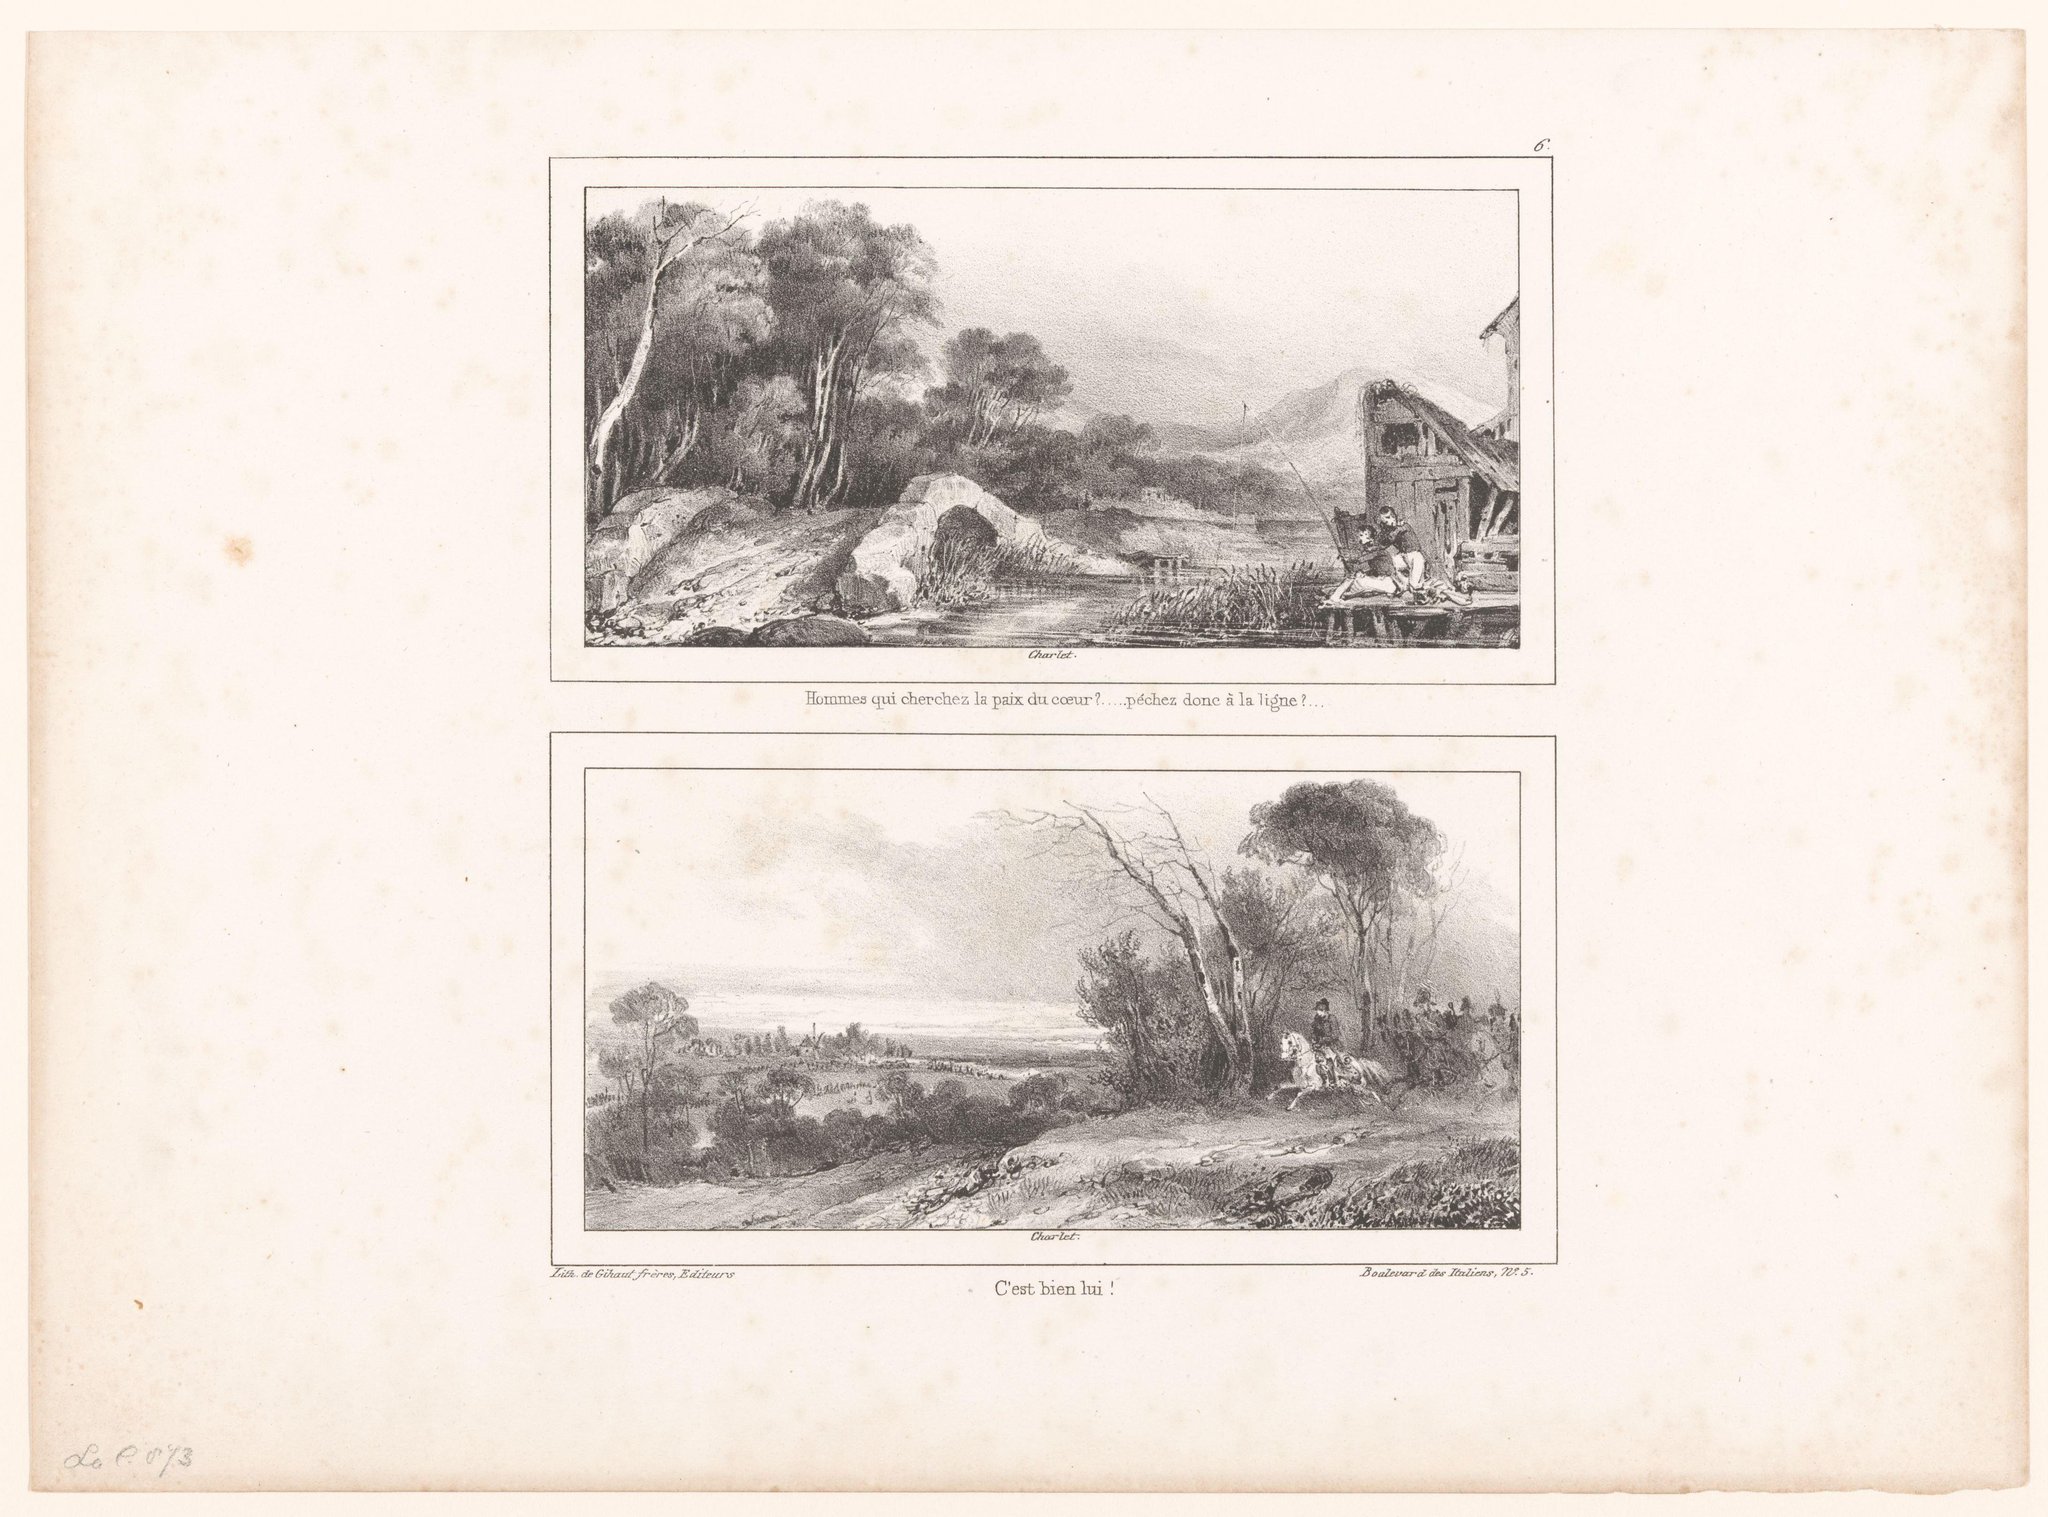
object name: print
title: Landschap met Napoleon te paard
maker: nicolas toussaint charlet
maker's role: draughtsman, painter, print maker, printer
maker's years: 1792-1845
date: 1836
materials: paper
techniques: lithograph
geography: paris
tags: napoleon i (emperor of the french), commander-in-chief, general, marshal (+ cavalry, horsemen), landscape with bridge, viaduct or aqueduct, recreation ~ the soldier off duty, angling, fringe, edge of the wood (+ landscape with figures, staffage)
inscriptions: collector's mark: Lugt 2228a